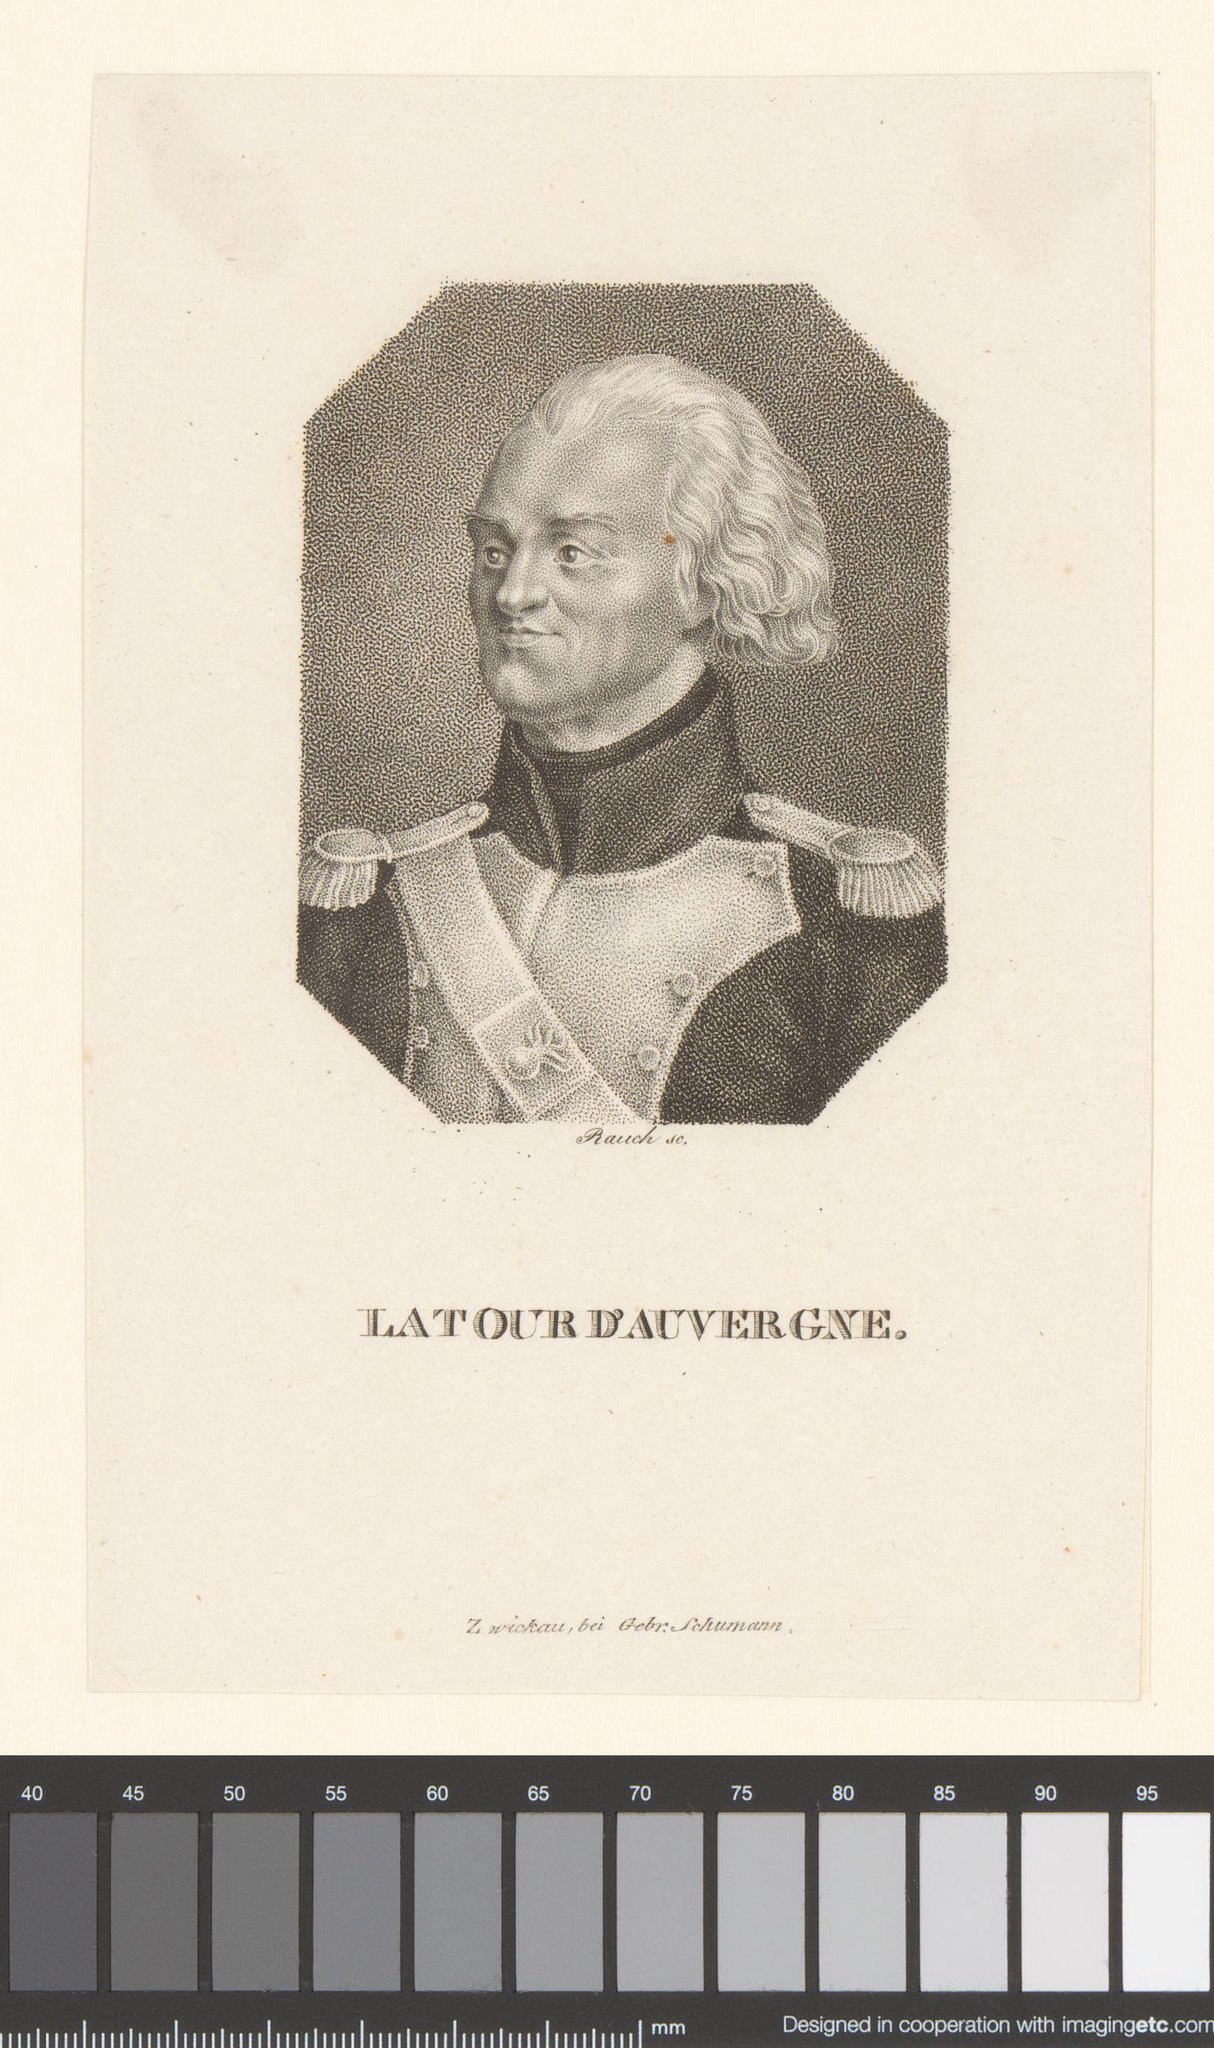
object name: print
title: Portret van Théophile Corret de la Tour d'Auvergne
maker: ernst rauch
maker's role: print maker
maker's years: 1797-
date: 1807-1899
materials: paper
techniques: engraving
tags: historical persons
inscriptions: collector's mark: Lugt 2228